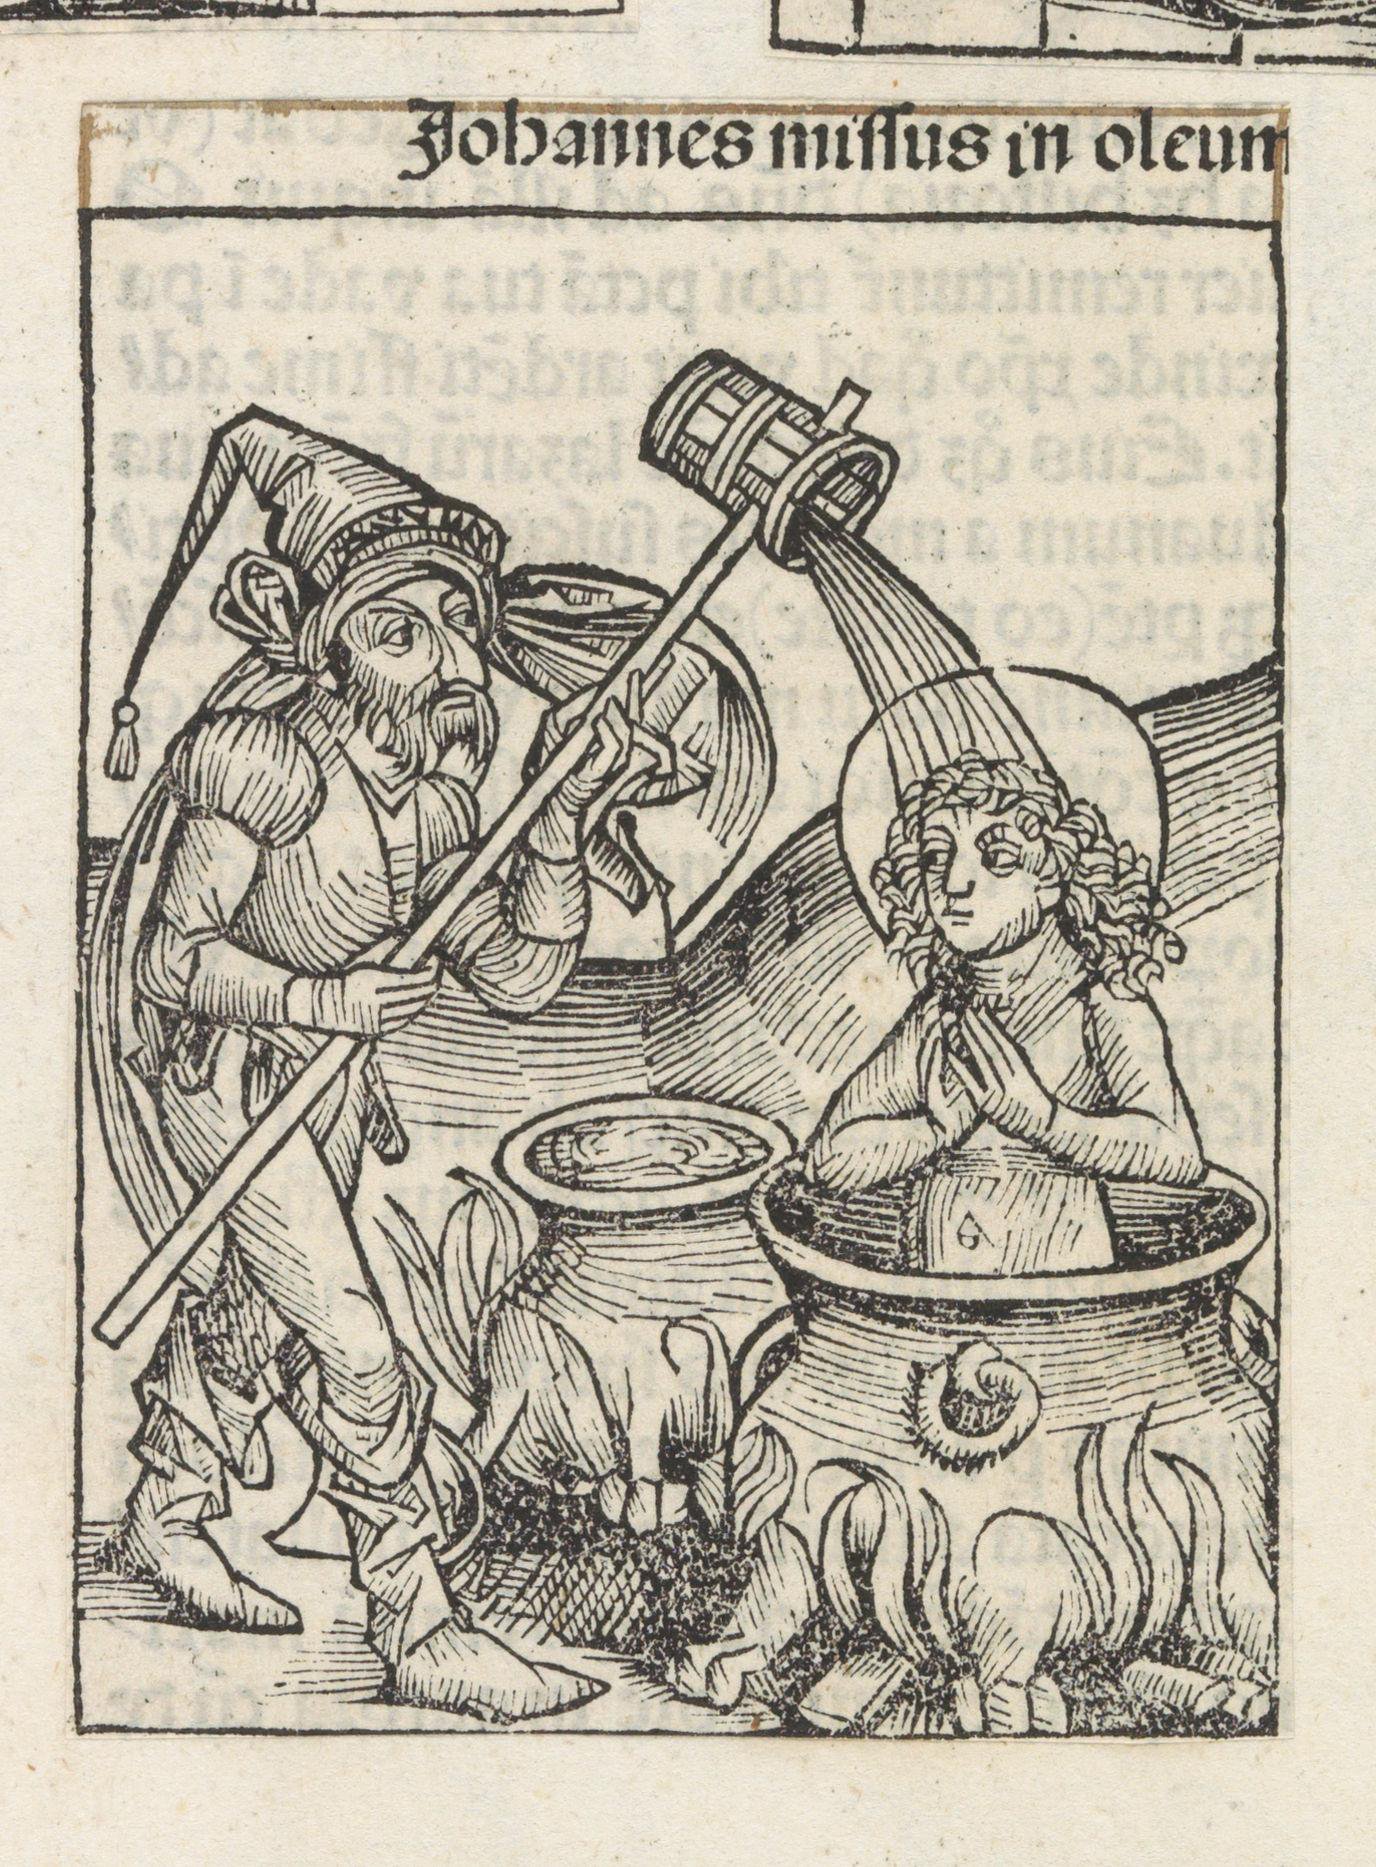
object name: album leaf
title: Liber Chronicarum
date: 1493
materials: paper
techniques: letterpress printing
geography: nuremberg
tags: martyrdom of john in front of the porta latina: he is put in a cauldron of boiling oil, but remains unharmed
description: Apostel Johannes de Evangelist zit in een pan met kokende olie. Zijn handen zijn gevouwen in gebed. Een man schept olie over zijn hoofd. Johannes kwam er op miraculeuze wijze ongedeerd uit. De prent maakt deel uit van een album.